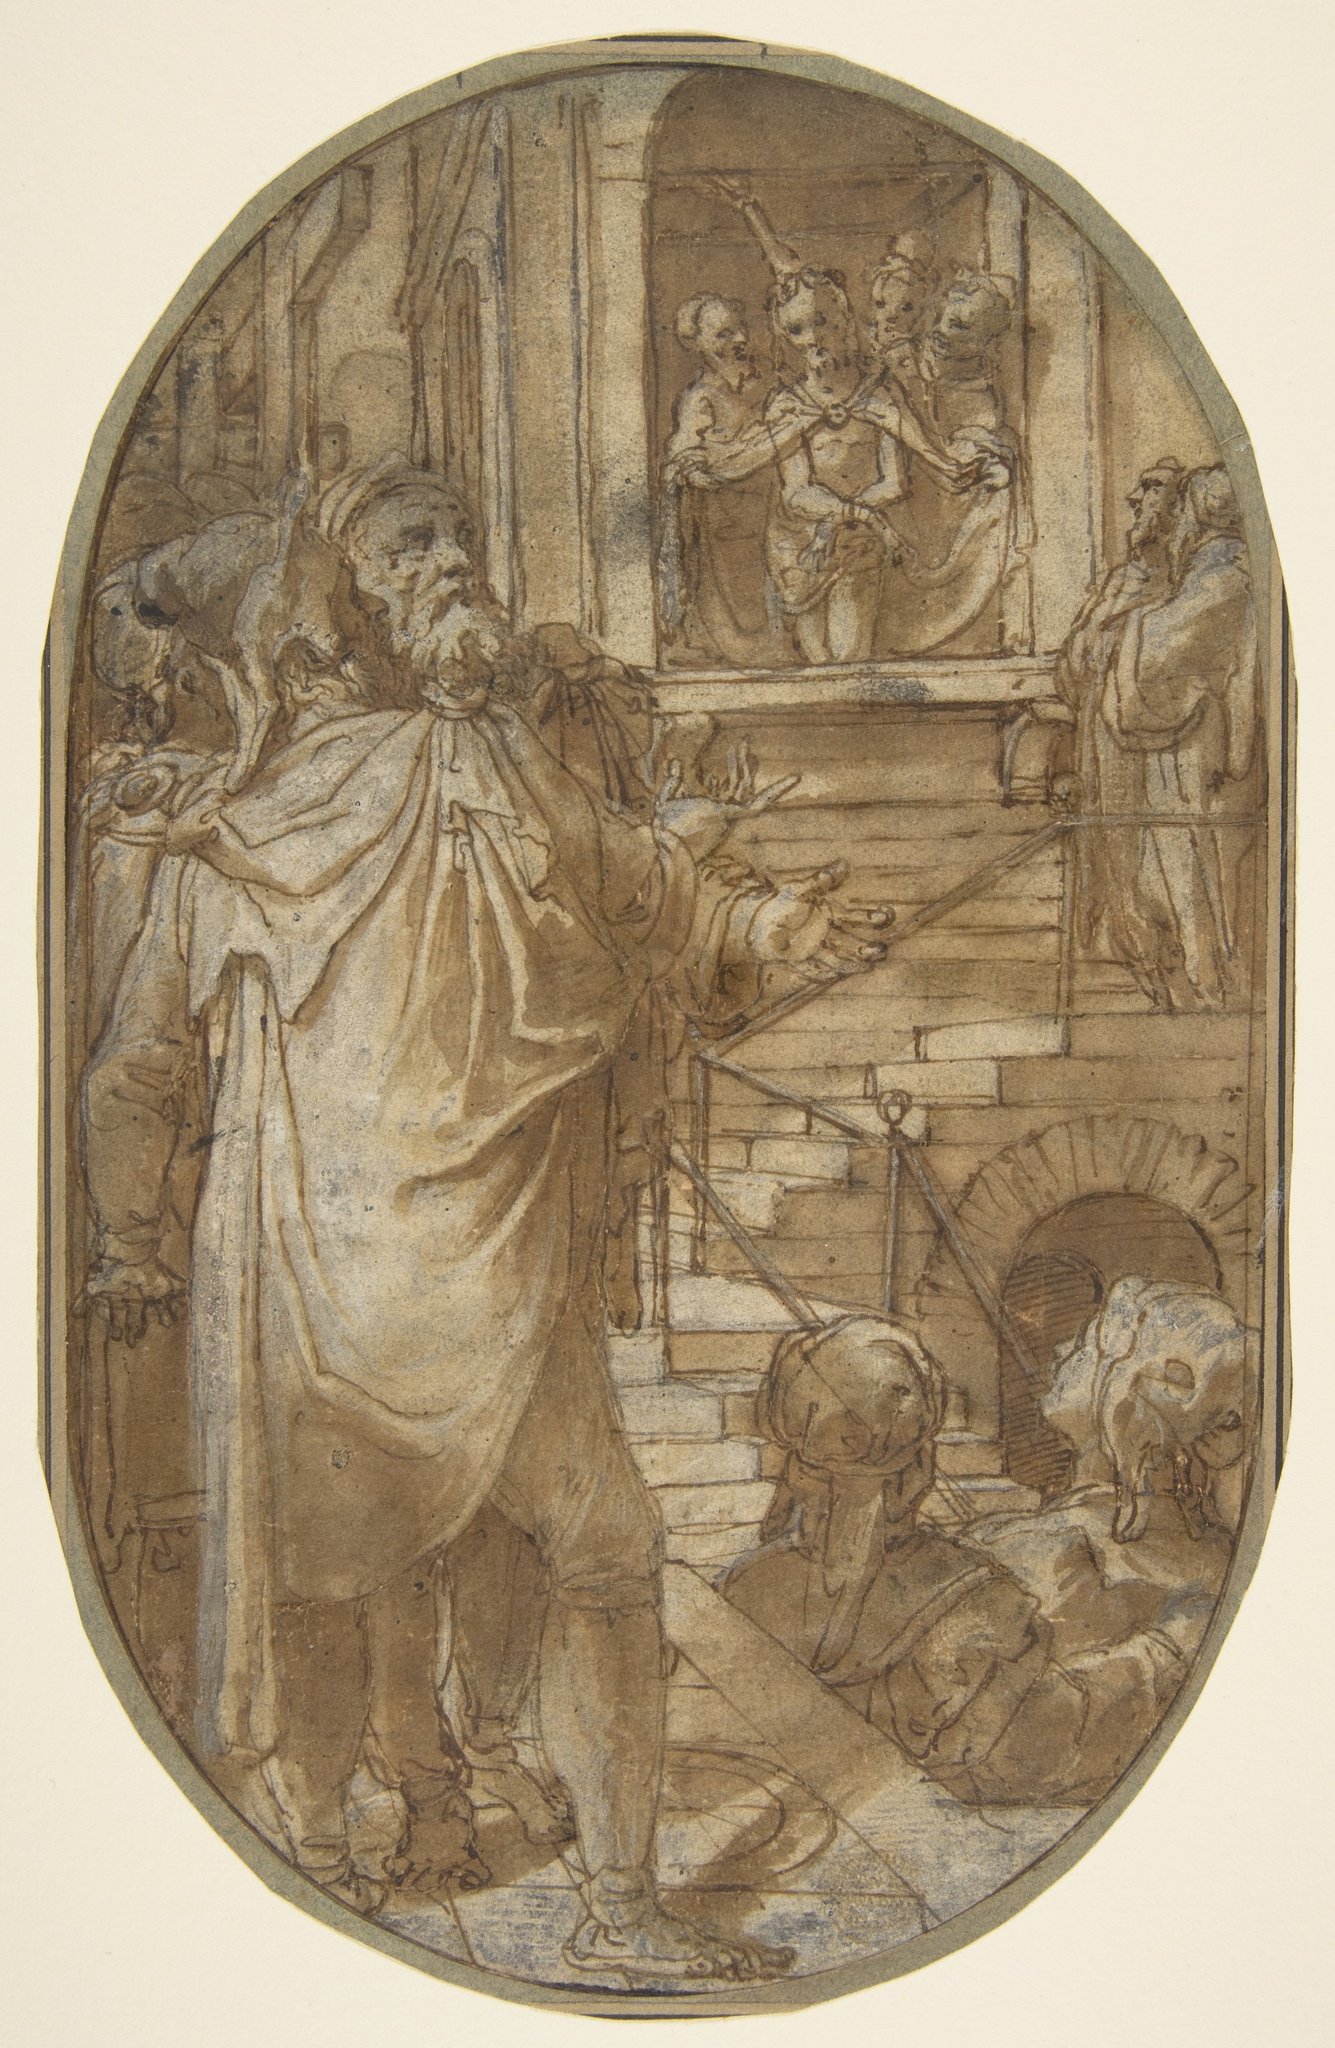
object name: drawing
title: Ecce Homo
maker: federico zuccaro (zuccari)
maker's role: artist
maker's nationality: italian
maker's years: 1540-1609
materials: ink, paper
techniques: brush, highlighting, pen, wash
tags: men,christ